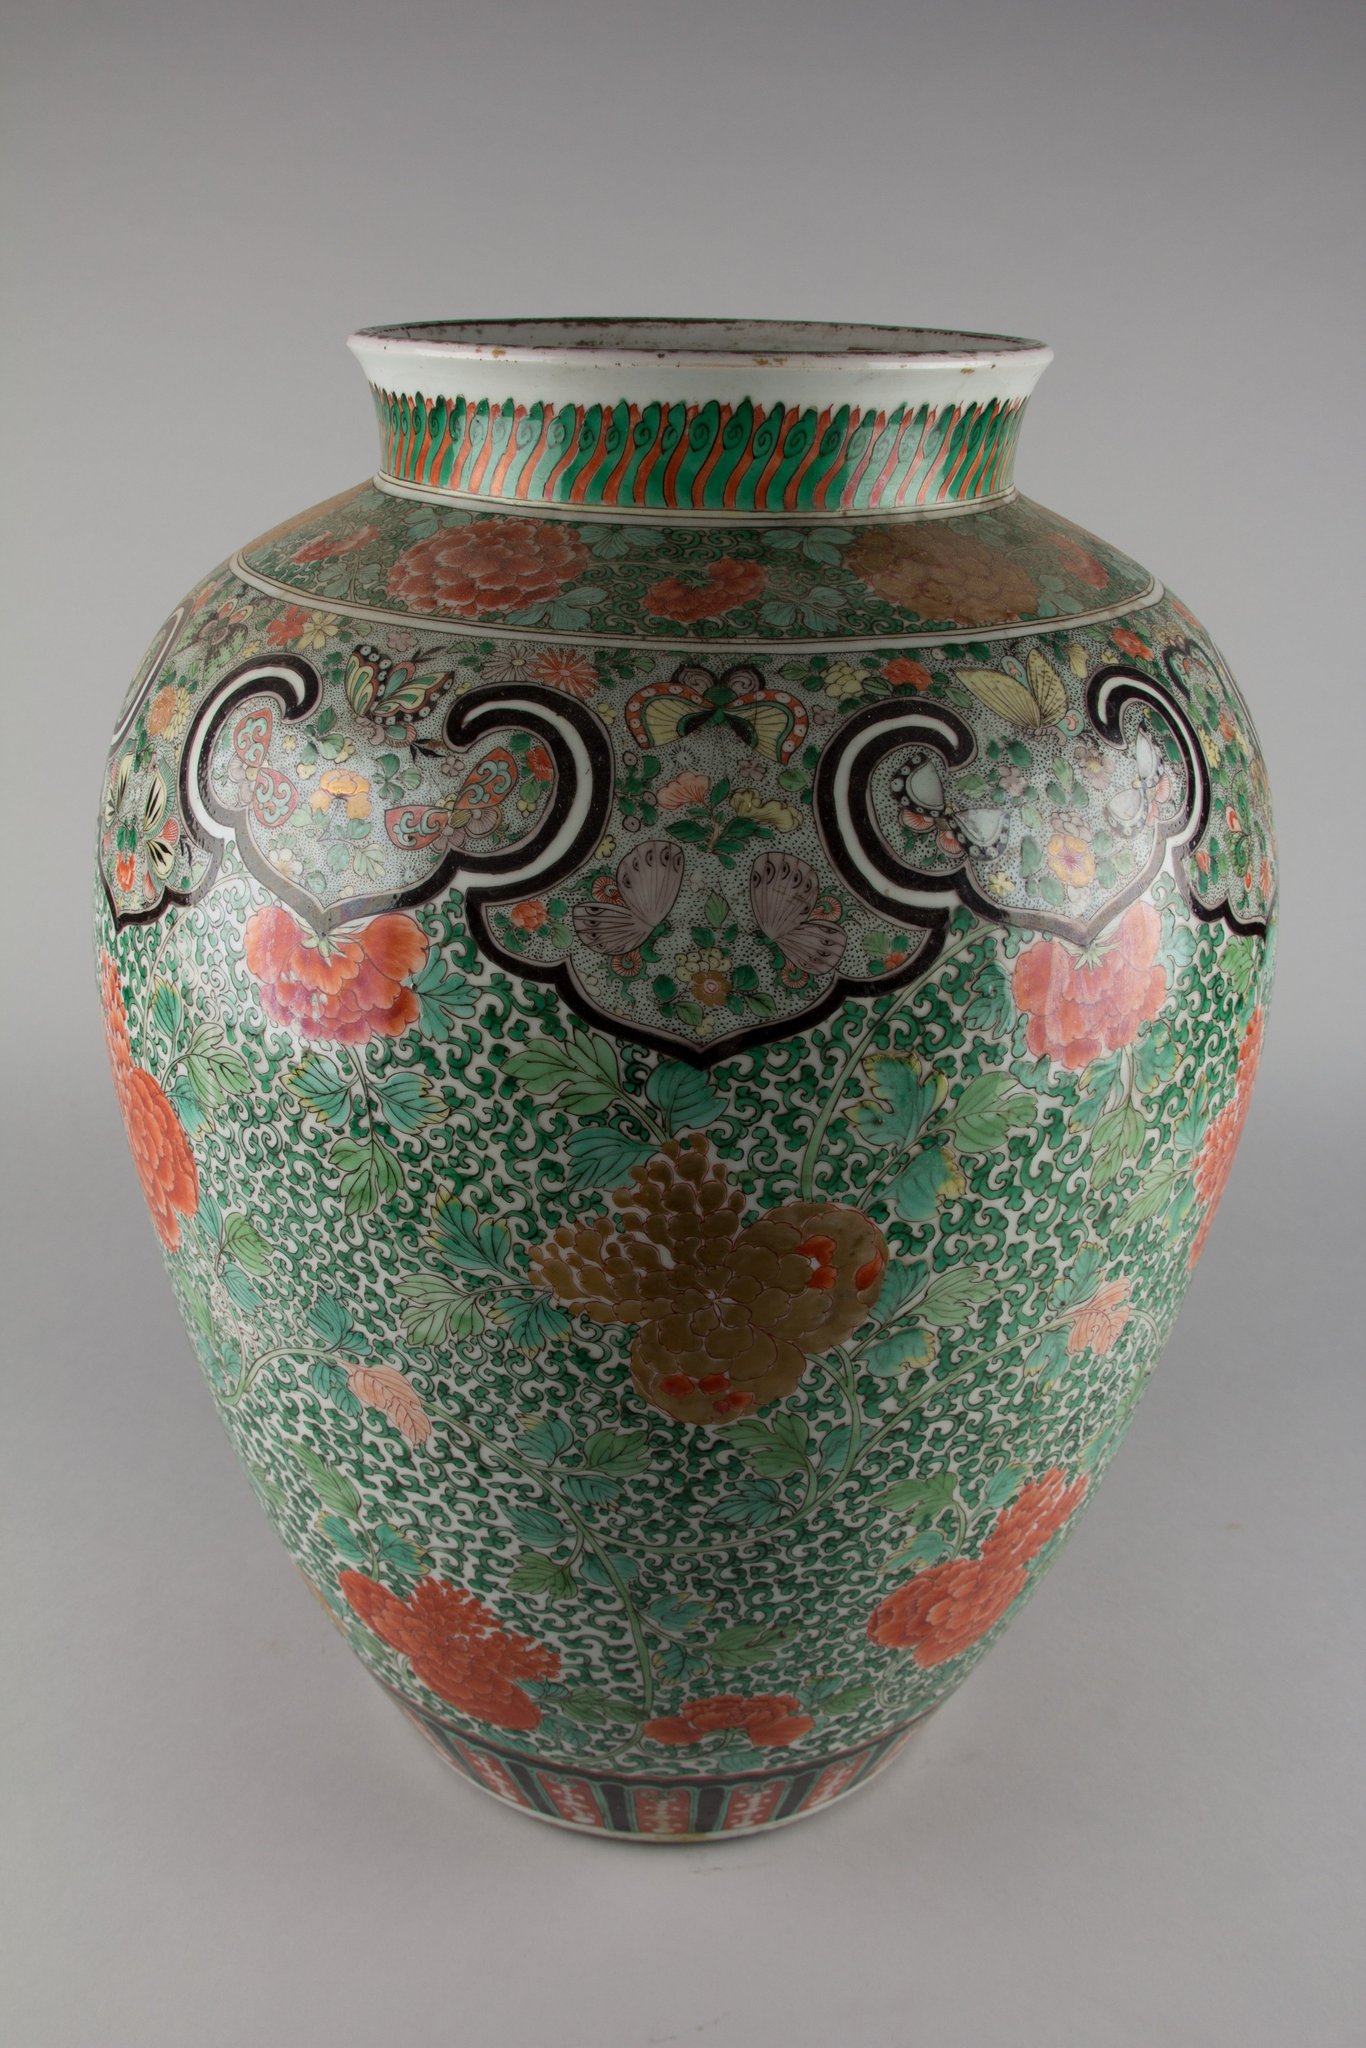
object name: jar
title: Jar with floral patterns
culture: chinese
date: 1667-1733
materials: enamel, porcelain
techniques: overglaze, painting, polychrome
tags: flowers